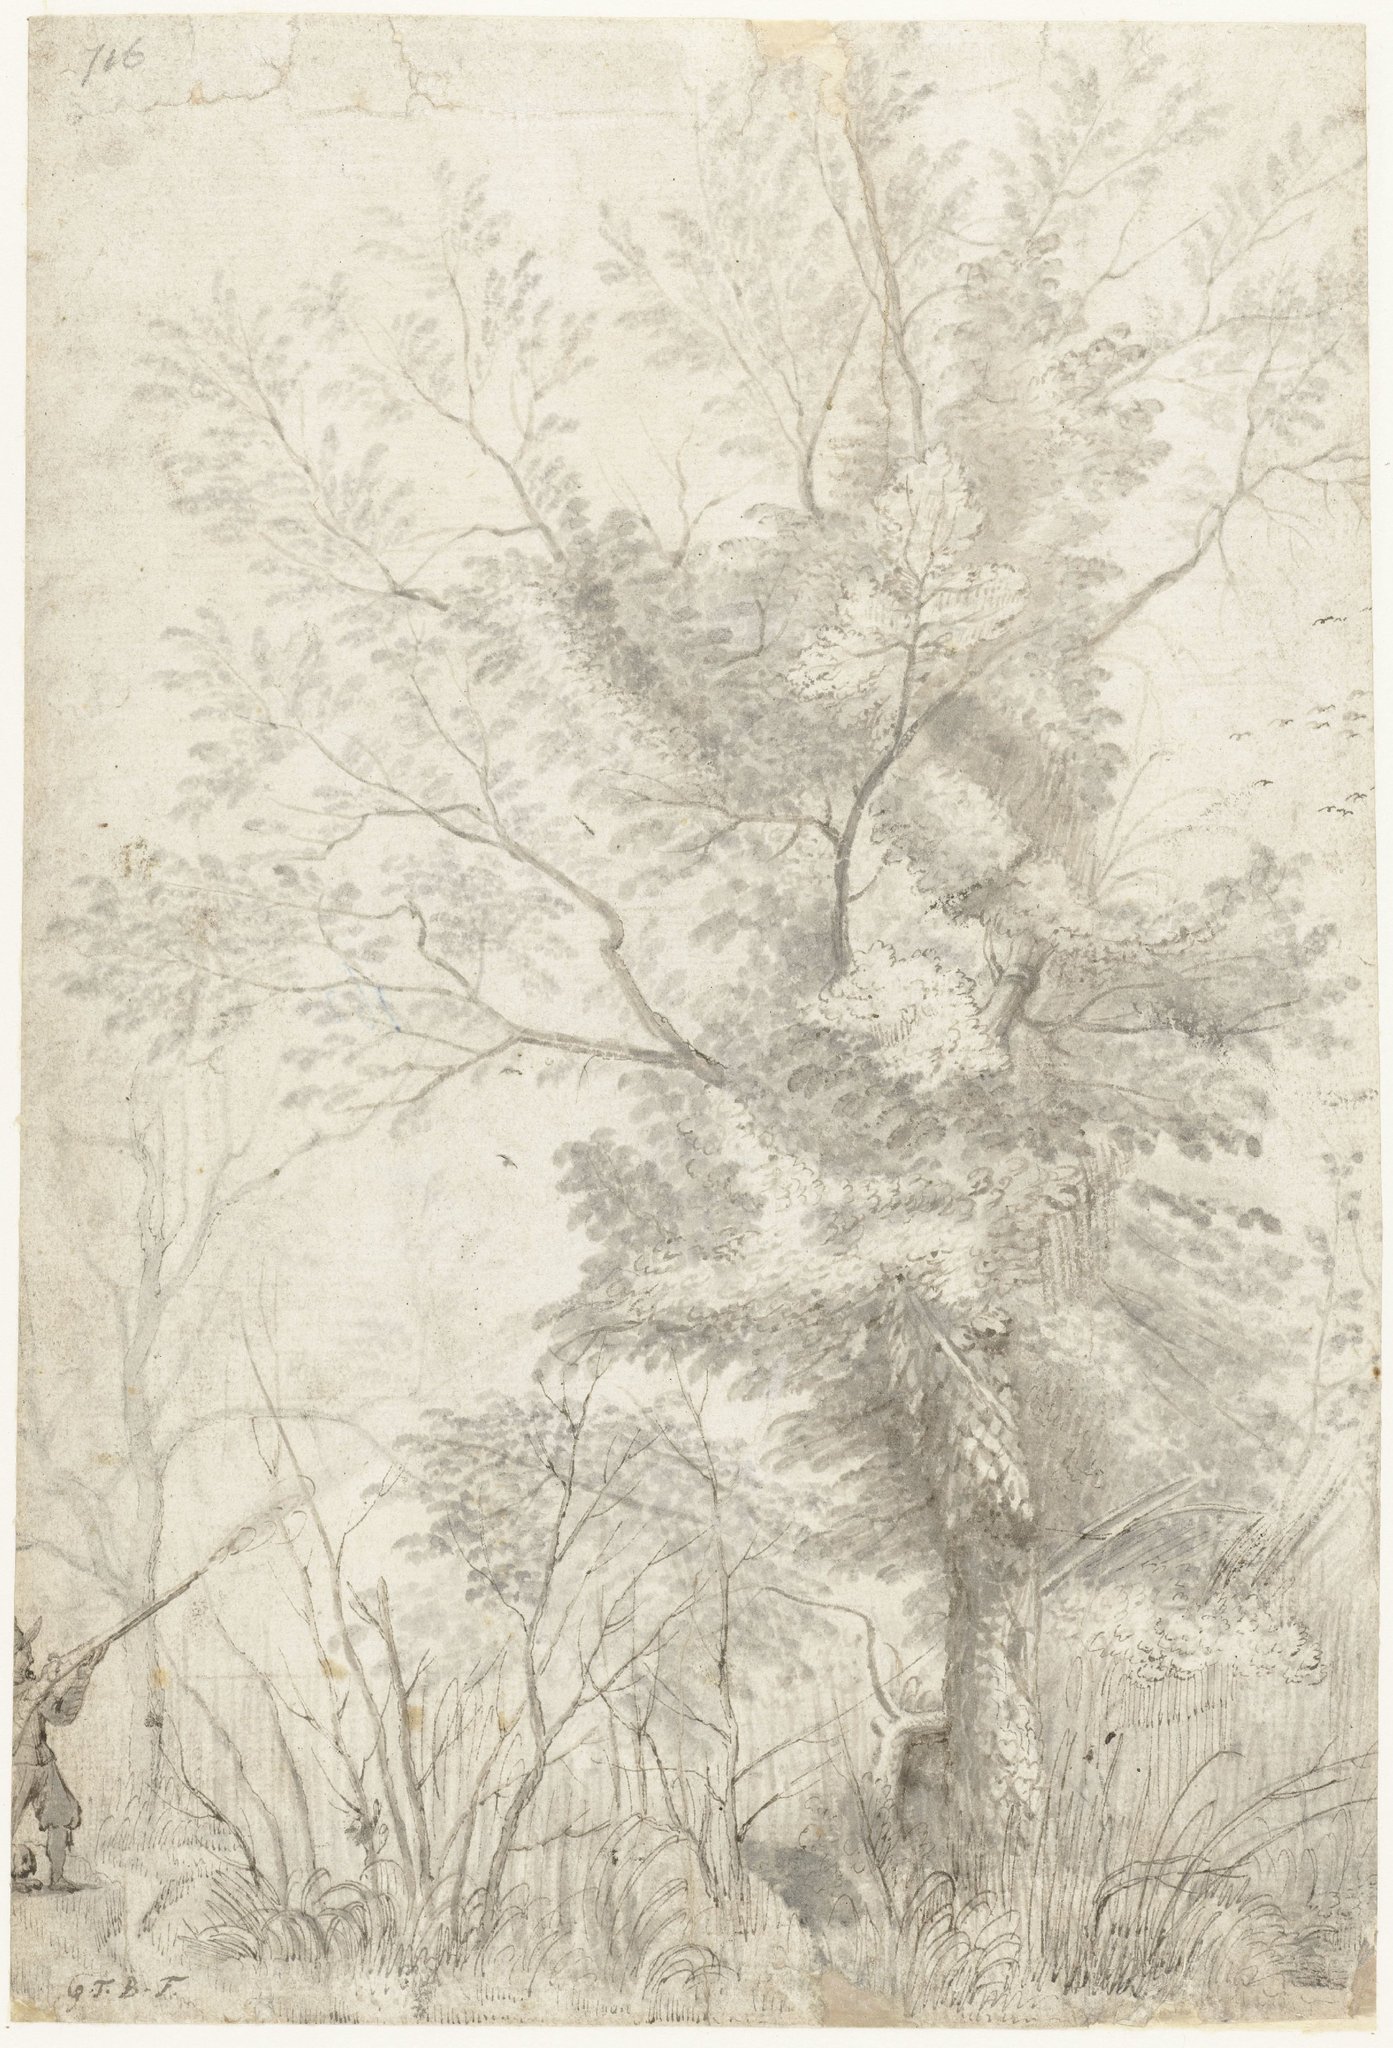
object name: drawing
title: Bos van de Villa Madama buiten Rome, met een schietende jager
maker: gerard ter borch (i)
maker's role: draughtsman, print maker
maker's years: 1584-1662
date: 1610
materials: chalk, ink, paper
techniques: brush, pen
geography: rome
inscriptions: monogram: ‘G.T.B.F.’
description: Tekening uit het Romeinse schetsboek van de kunstenaar.